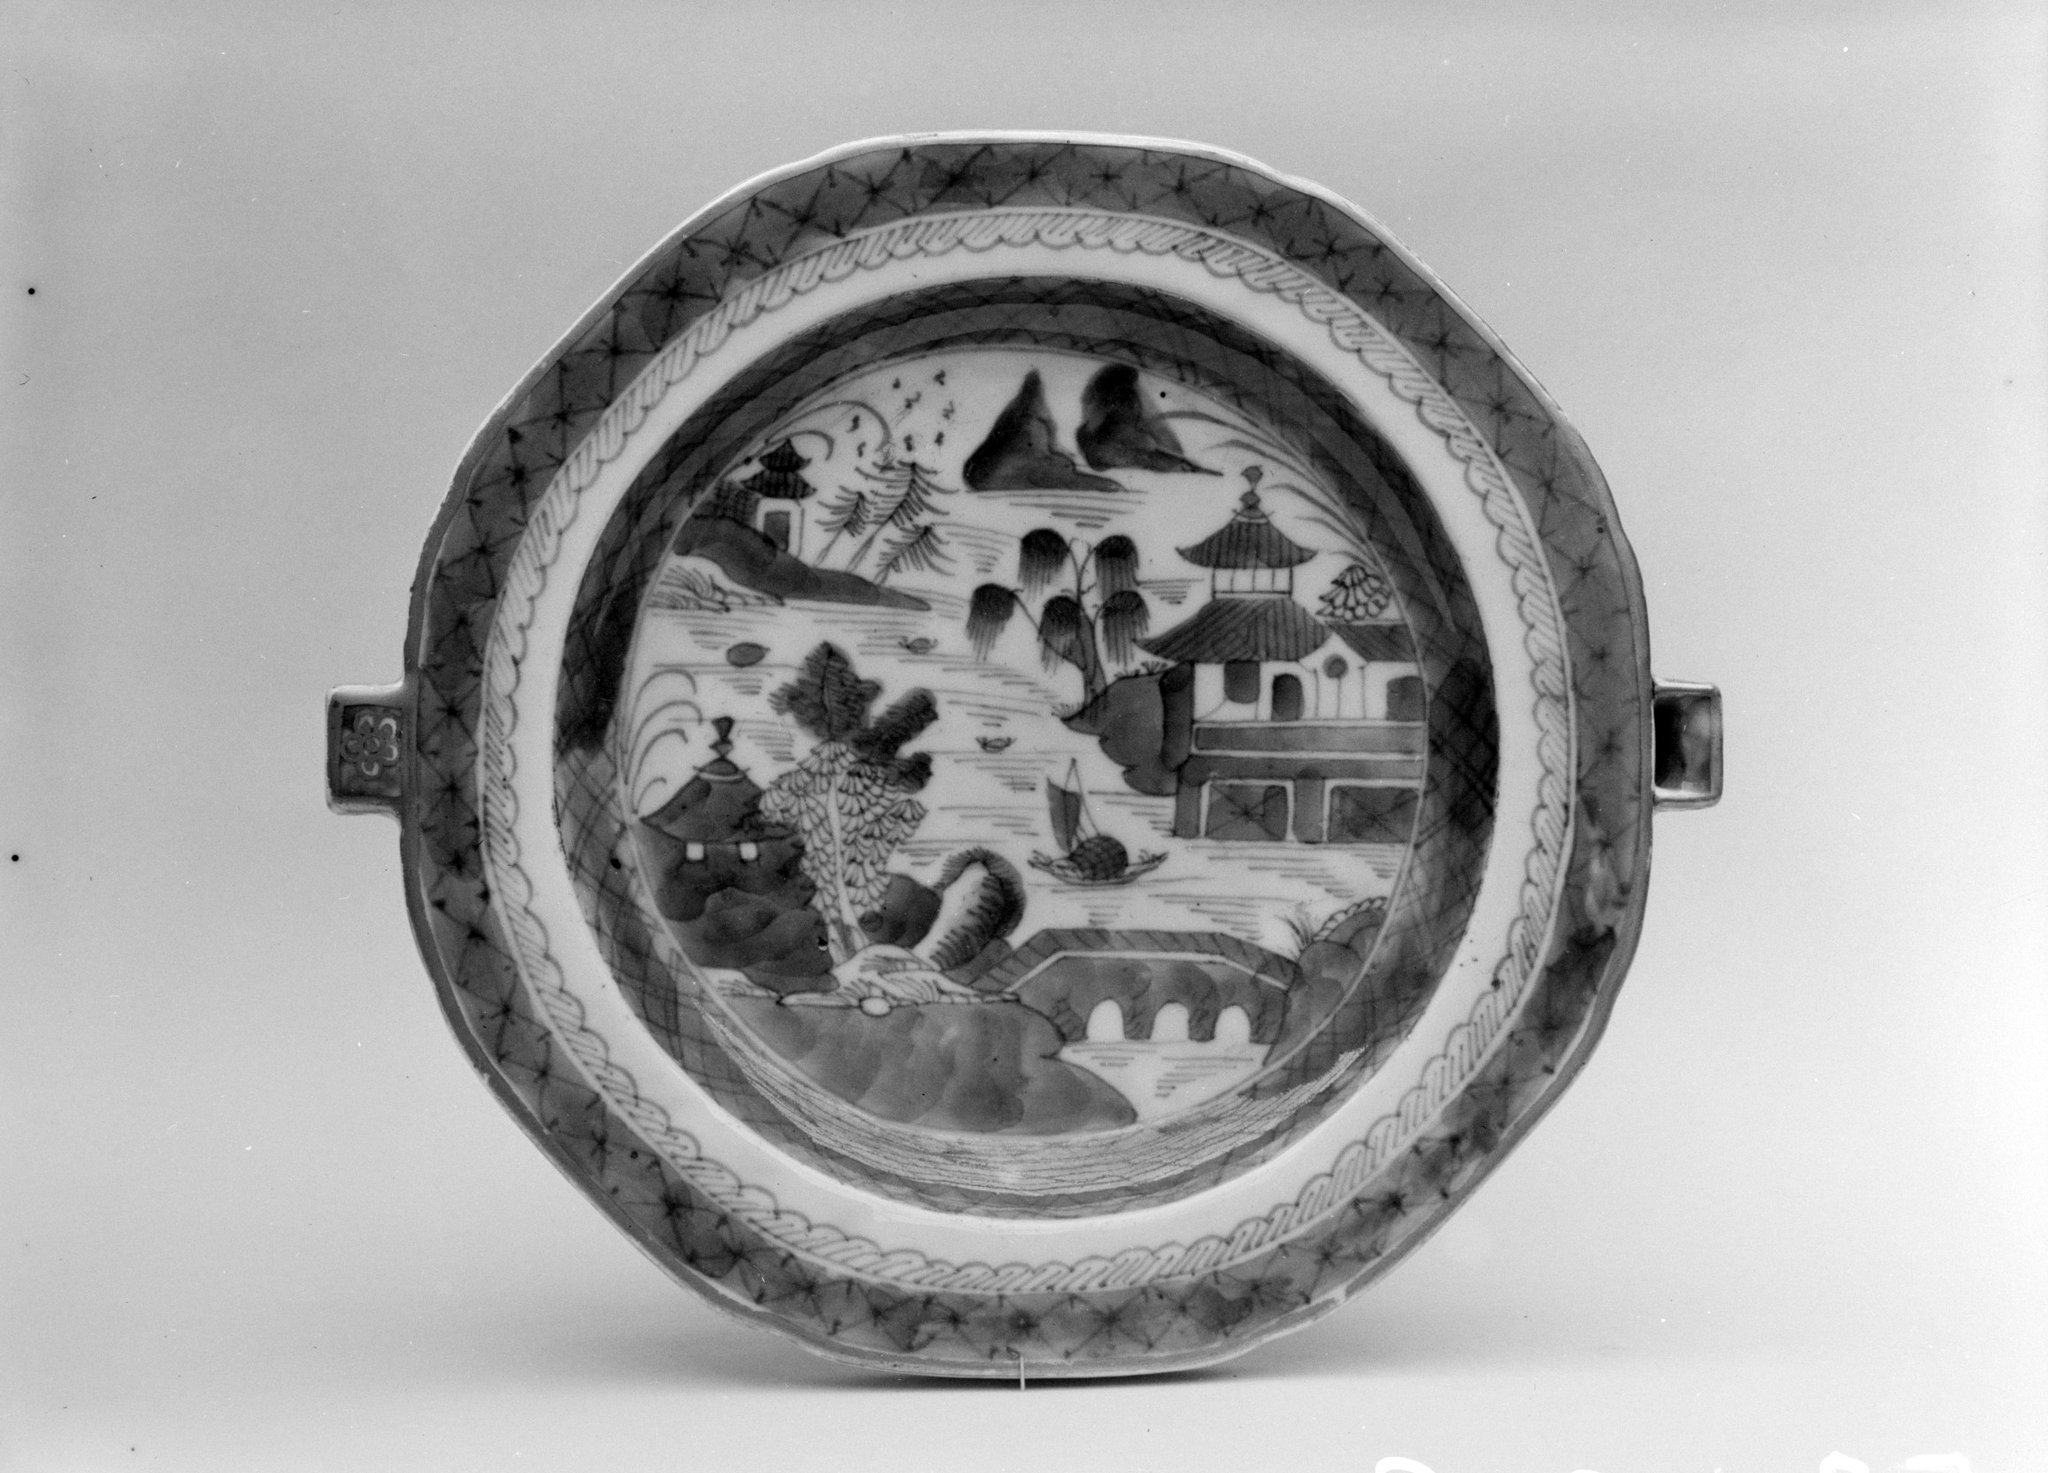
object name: hot water plate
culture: chinese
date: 1800-1830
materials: porcelain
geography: china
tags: landscapes,boats